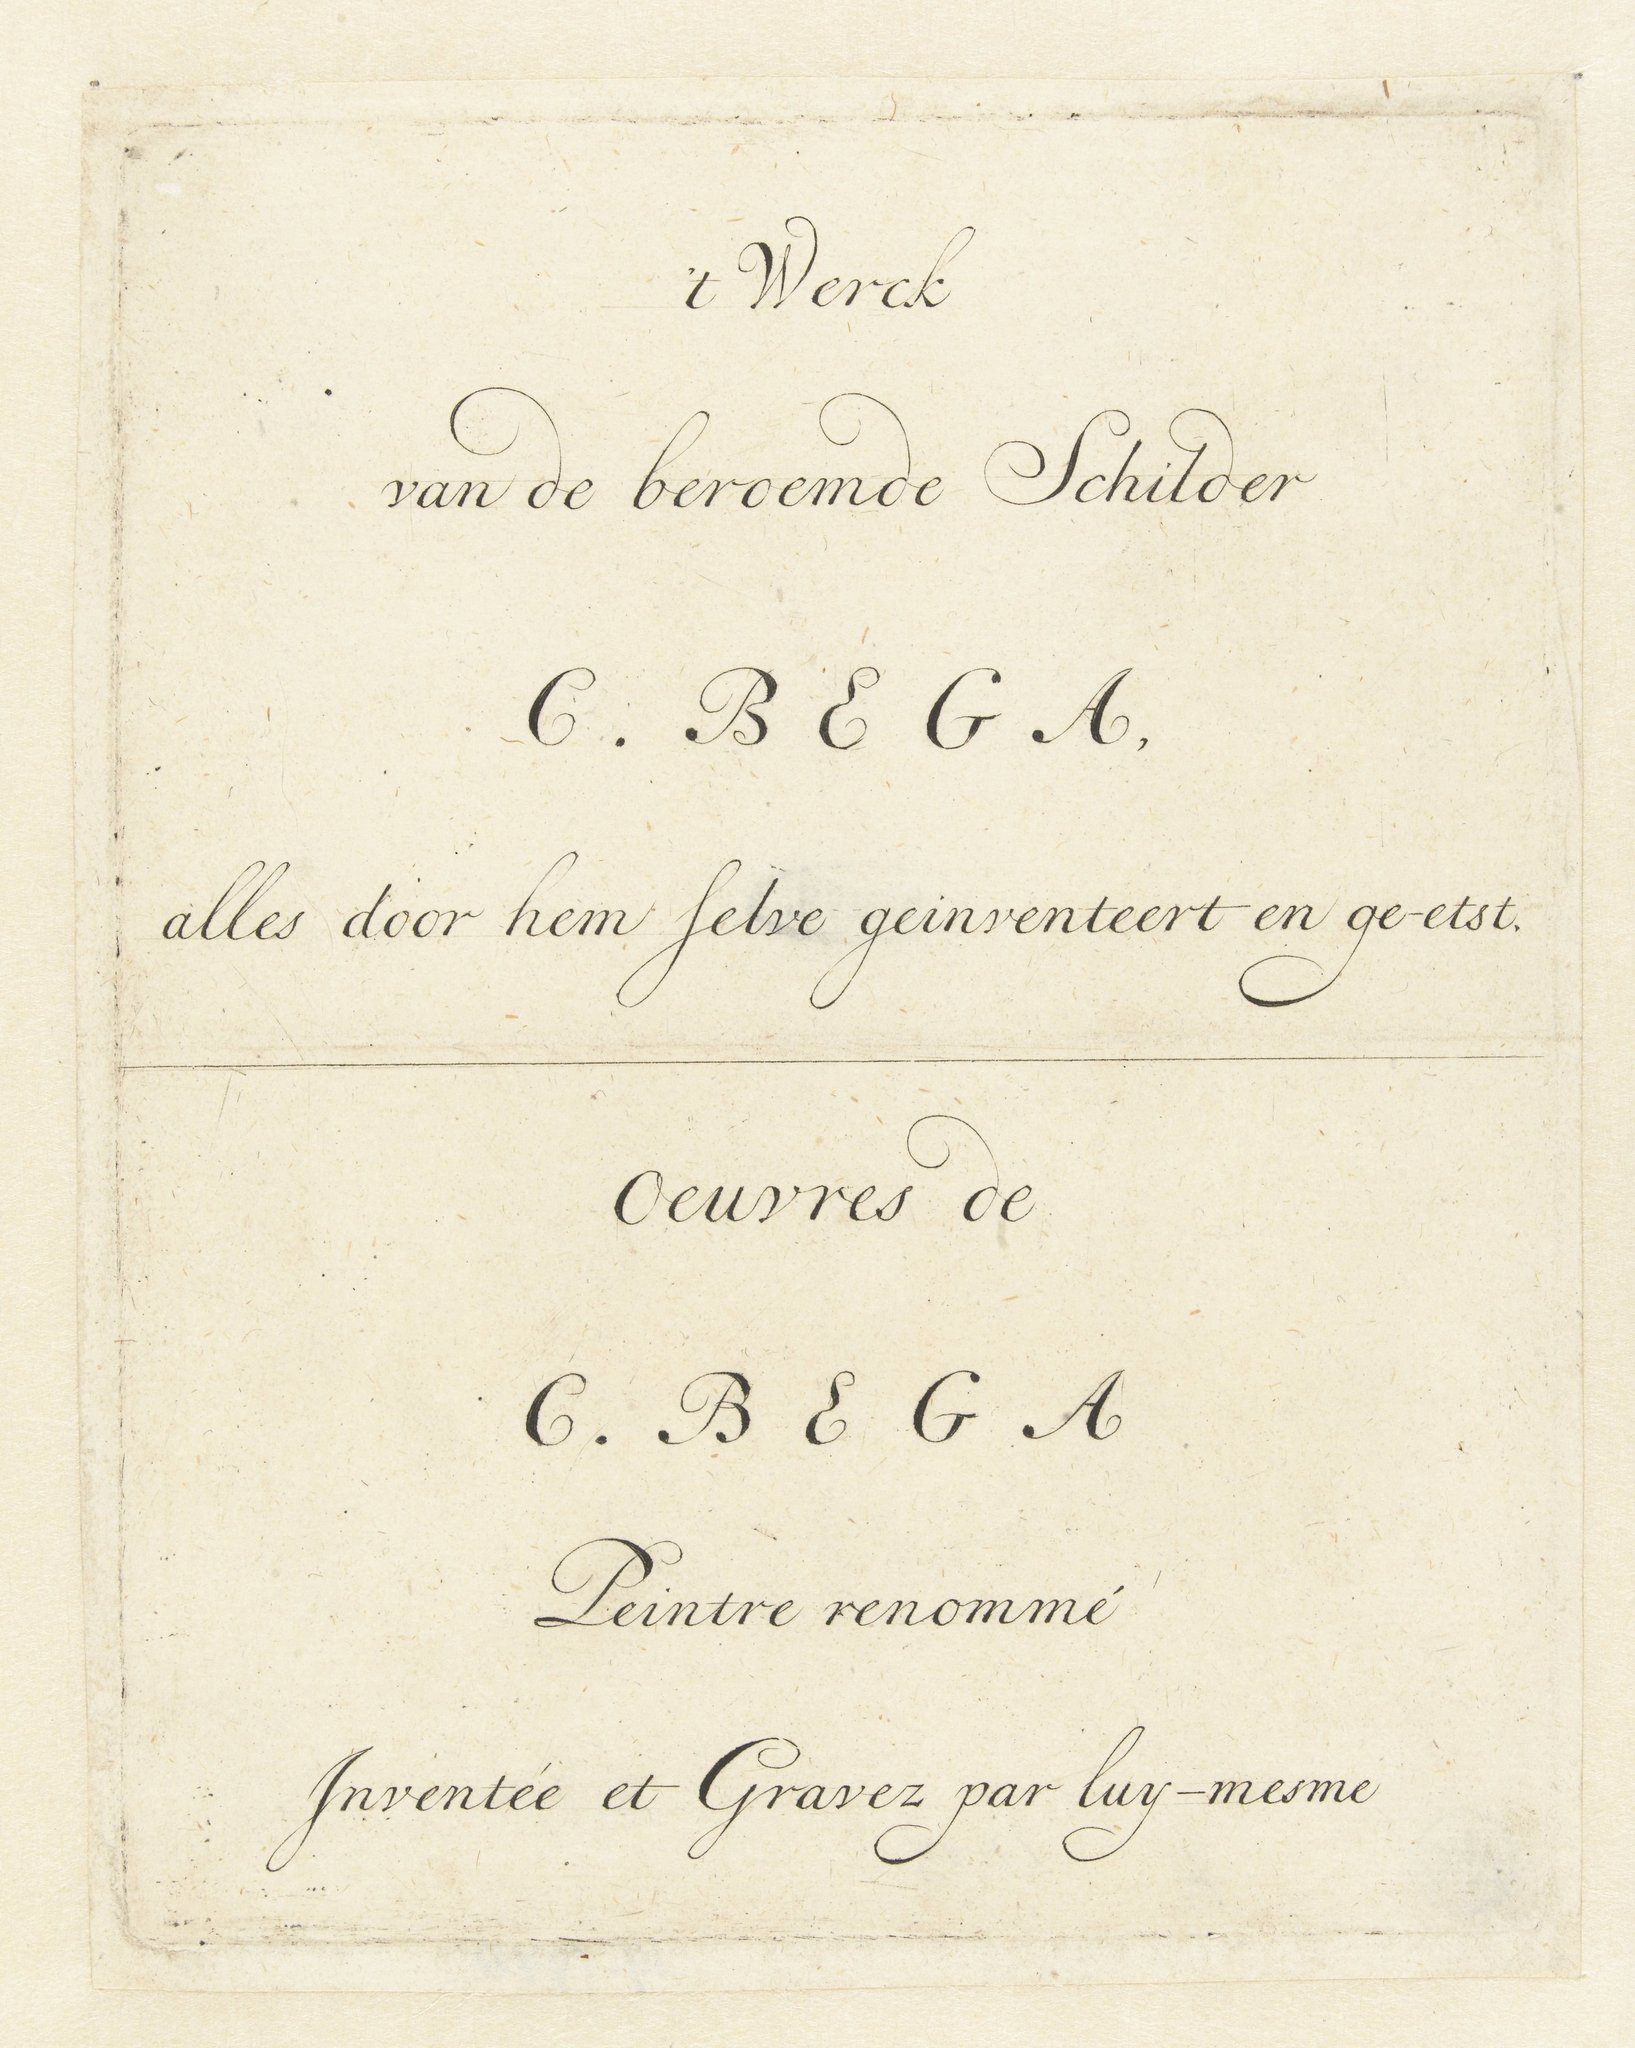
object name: print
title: 't Werk van de beroemde schilder C. Bega alles door hem Selve geinventeert en ge-etst/ Oeuvres de C. Bega Peintre renommé Inventée et Gravez par luy-mesme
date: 1710-1735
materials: paper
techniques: etching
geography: netherlands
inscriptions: collector's mark: Lugt 2233, collector's mark: Lugt 91, collector's mark: Lugt 2228